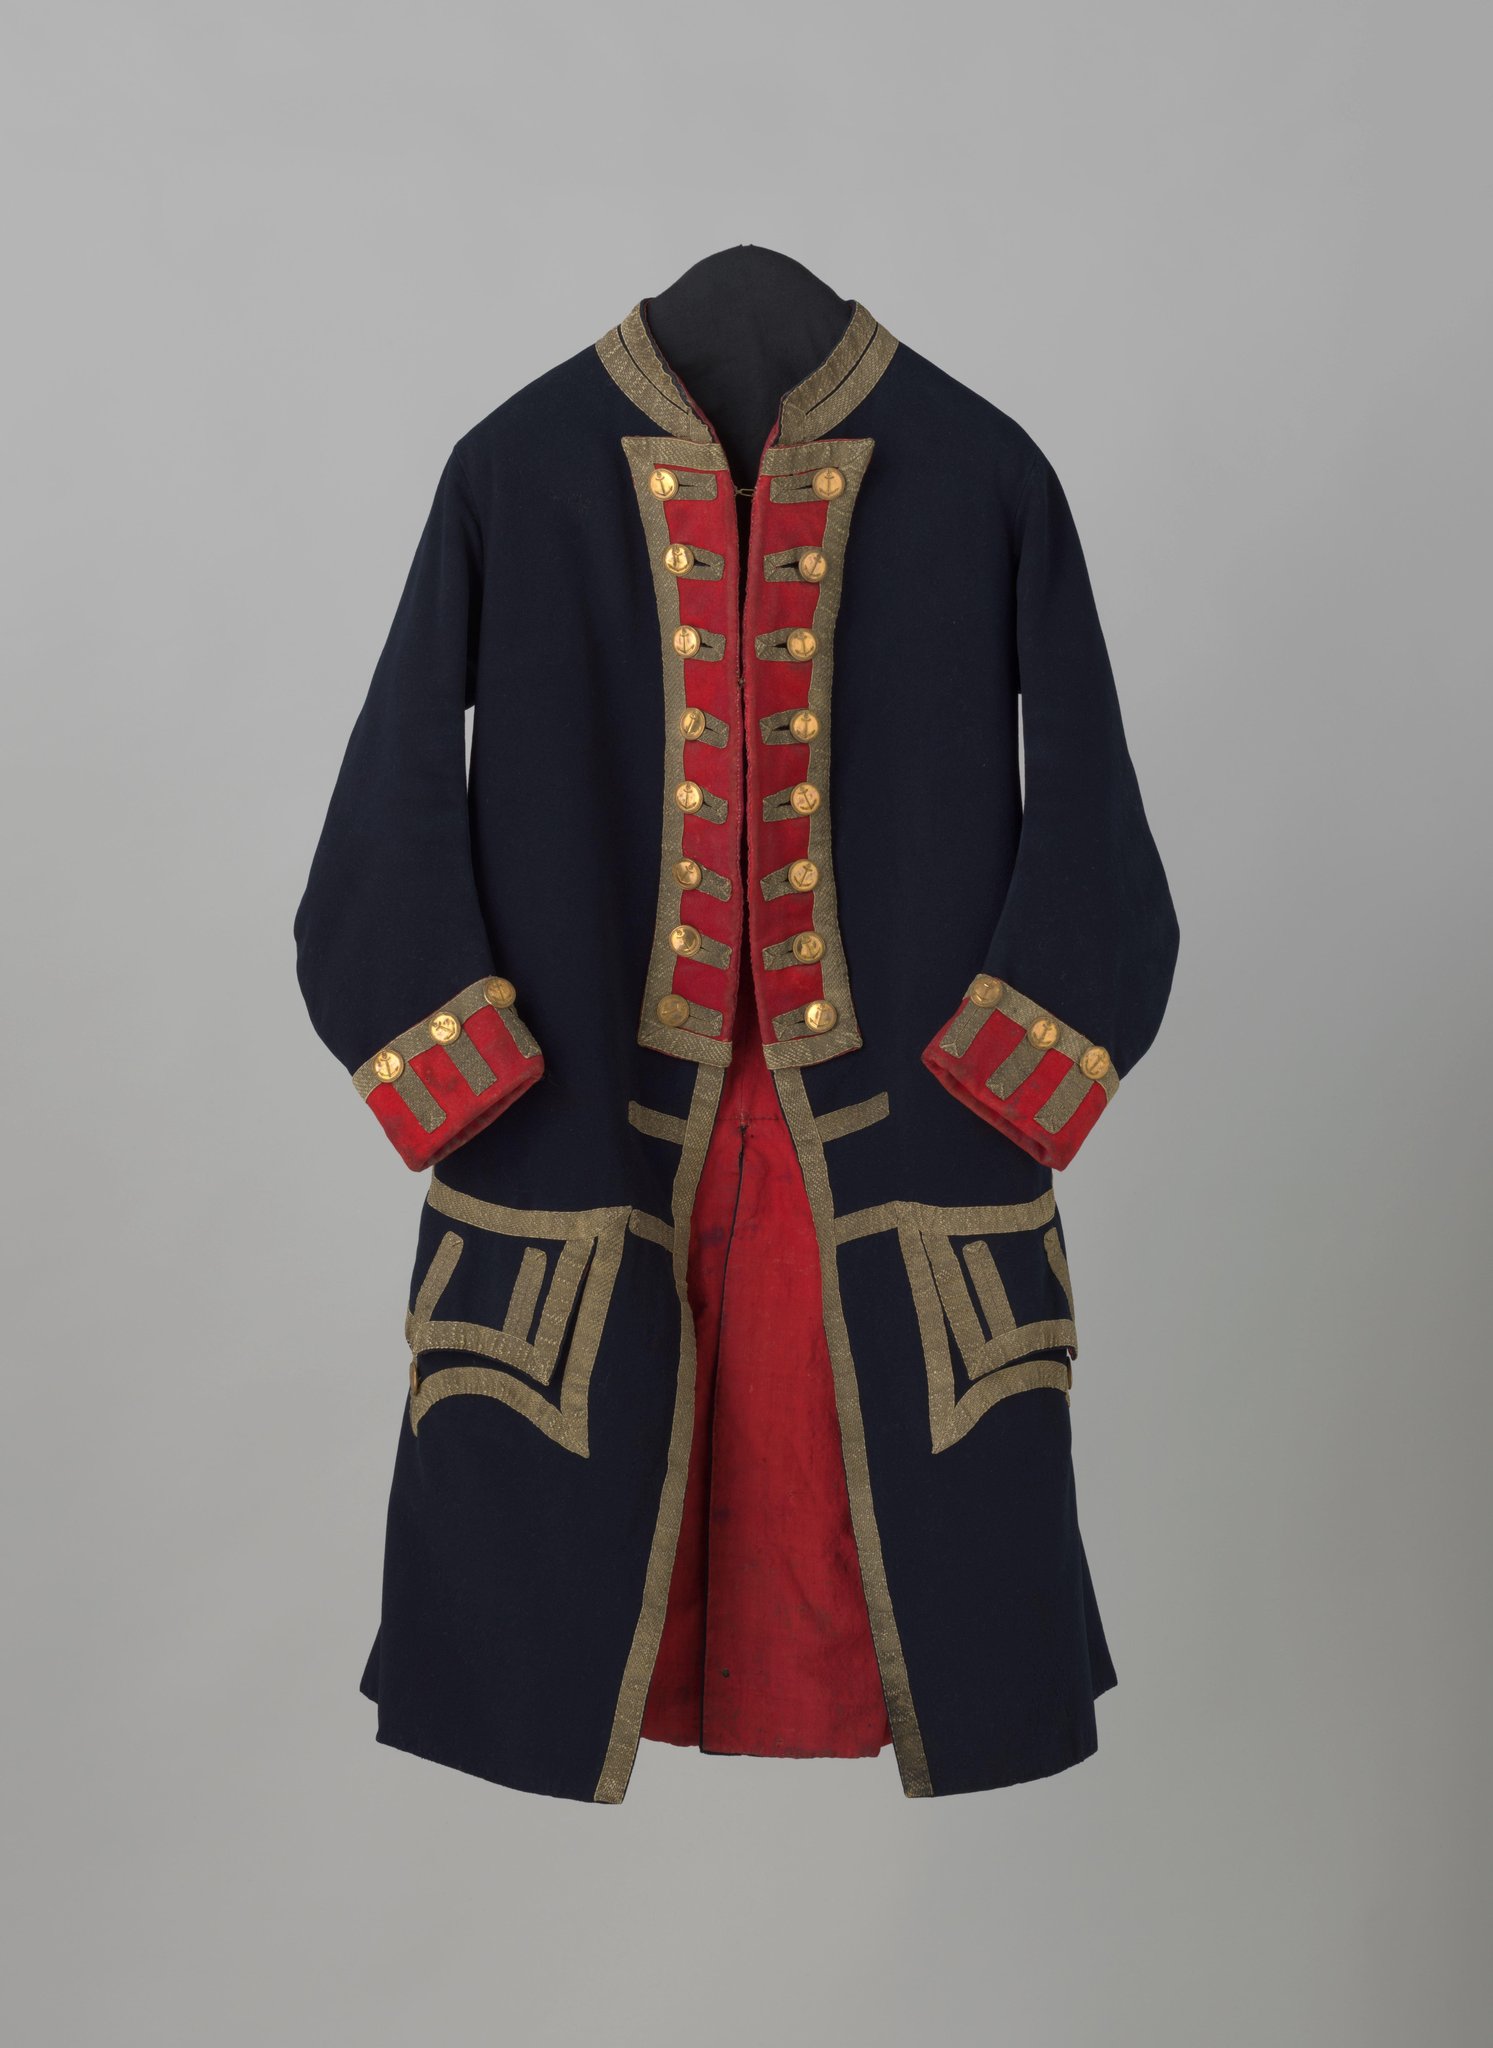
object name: uniformrok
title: Uniformrok van Willem Crul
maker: Anonymous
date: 1750-1775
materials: bone, copper, linen, silk, wool, yarns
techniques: sewing, weave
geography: netherlands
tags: willem crul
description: Willem Crul's uniform robe and yatagan, 18th century. Rear-Admiral Willem Crul (1721-1781) was unaware that war had started when a British fleet surrounded him in 1781 on his approach to St Eustatius. Crul thought that this was a courtesy visit and so decided to wear his official uniform. This made him an easy target for the British marksman who killed him. The 'yatagan' is a Turkish sabre. To own one was a sign of heroism and courage, and was identified with the Christian knights who fought the Turks.